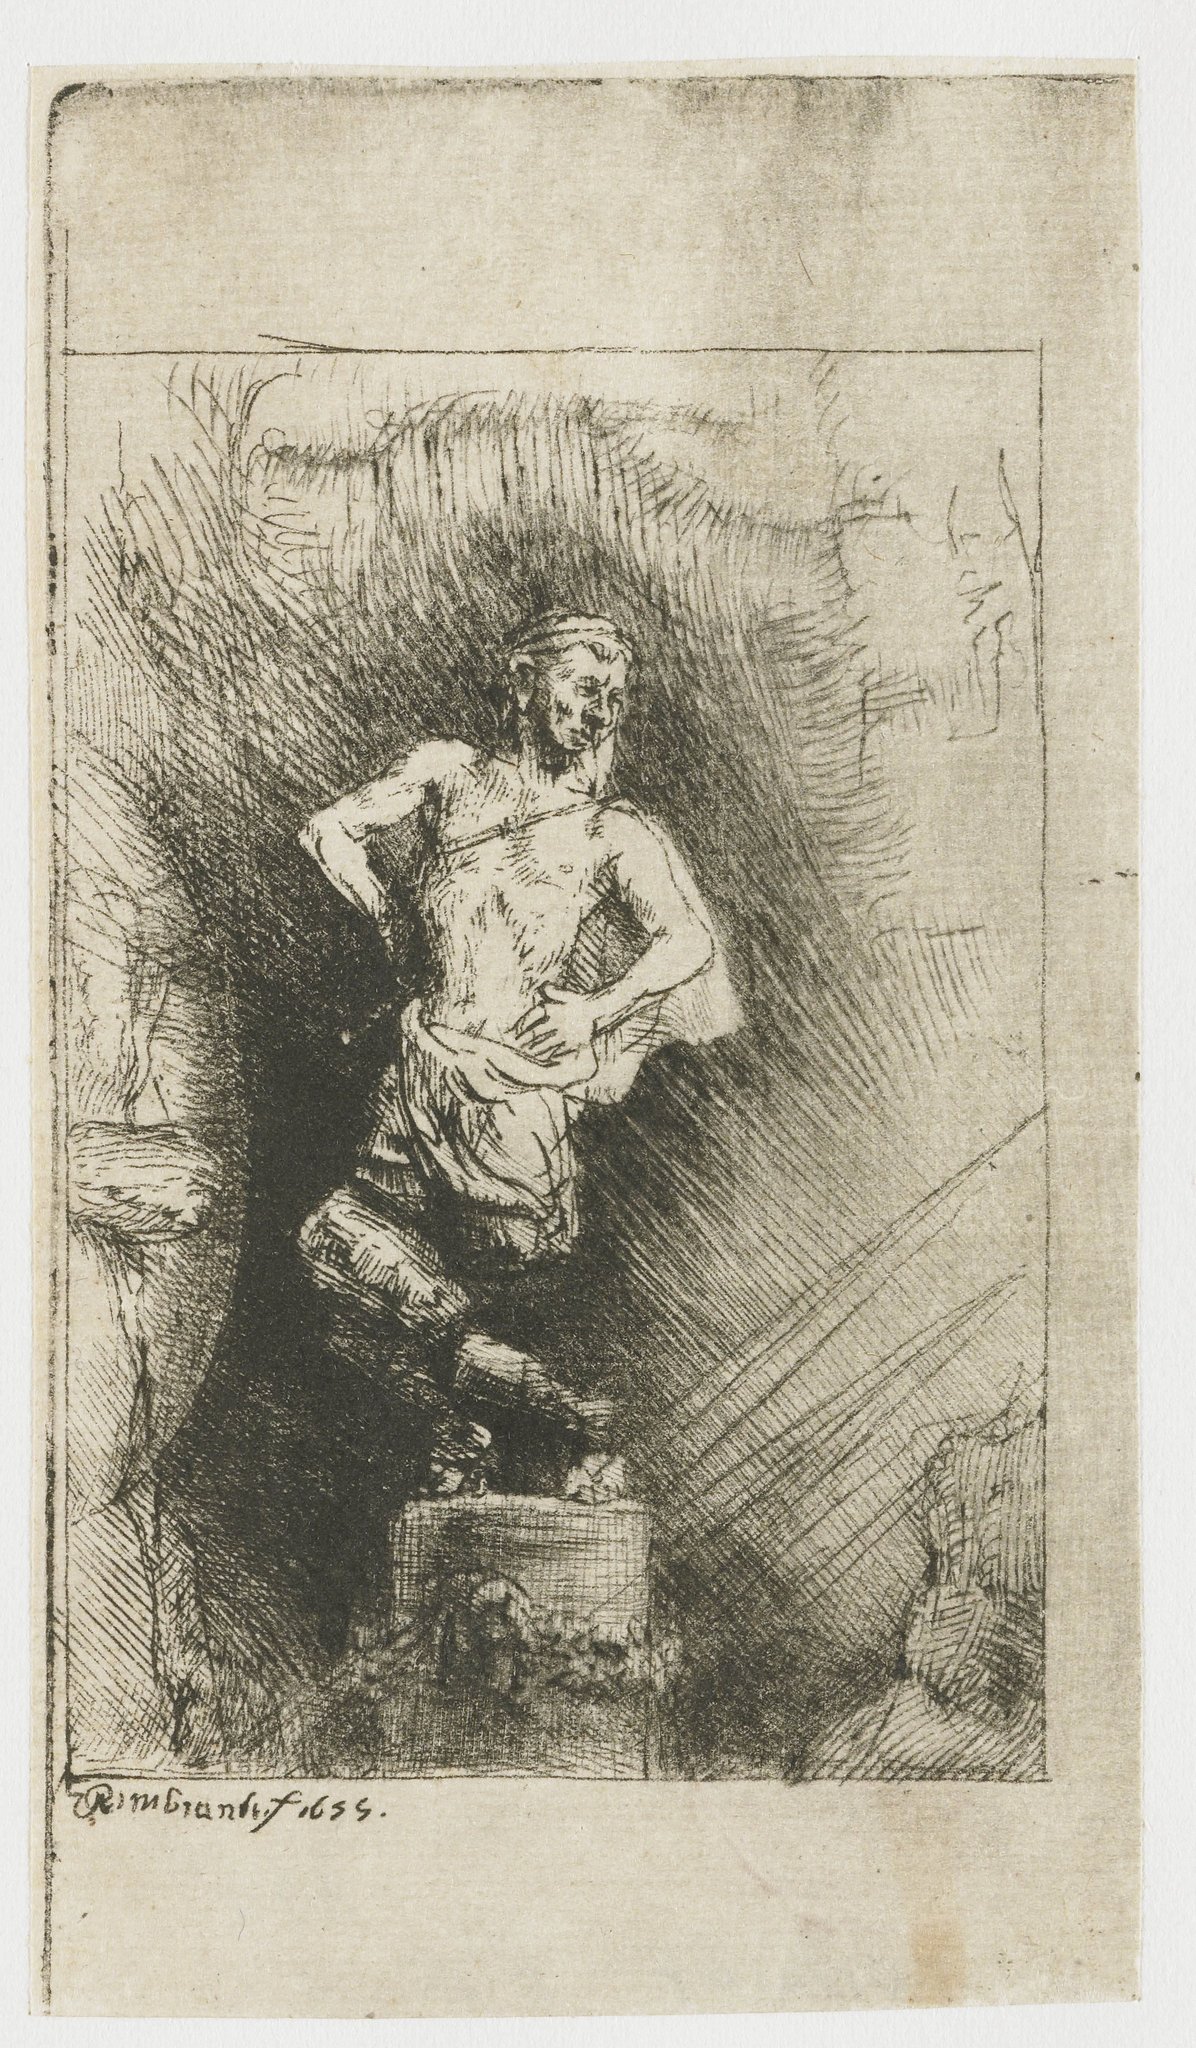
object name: print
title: The image seen by Nebuchadnezzar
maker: rembrandt van rijn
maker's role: draughtsman, painter, print maker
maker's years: 1606-1669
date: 1655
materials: paper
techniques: drypoint, etching, intaglio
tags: king nebuchadnezzar dreams of a great statue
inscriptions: collector's mark: Lugt 240, signature and date: ‘Rembrandt f 1655’